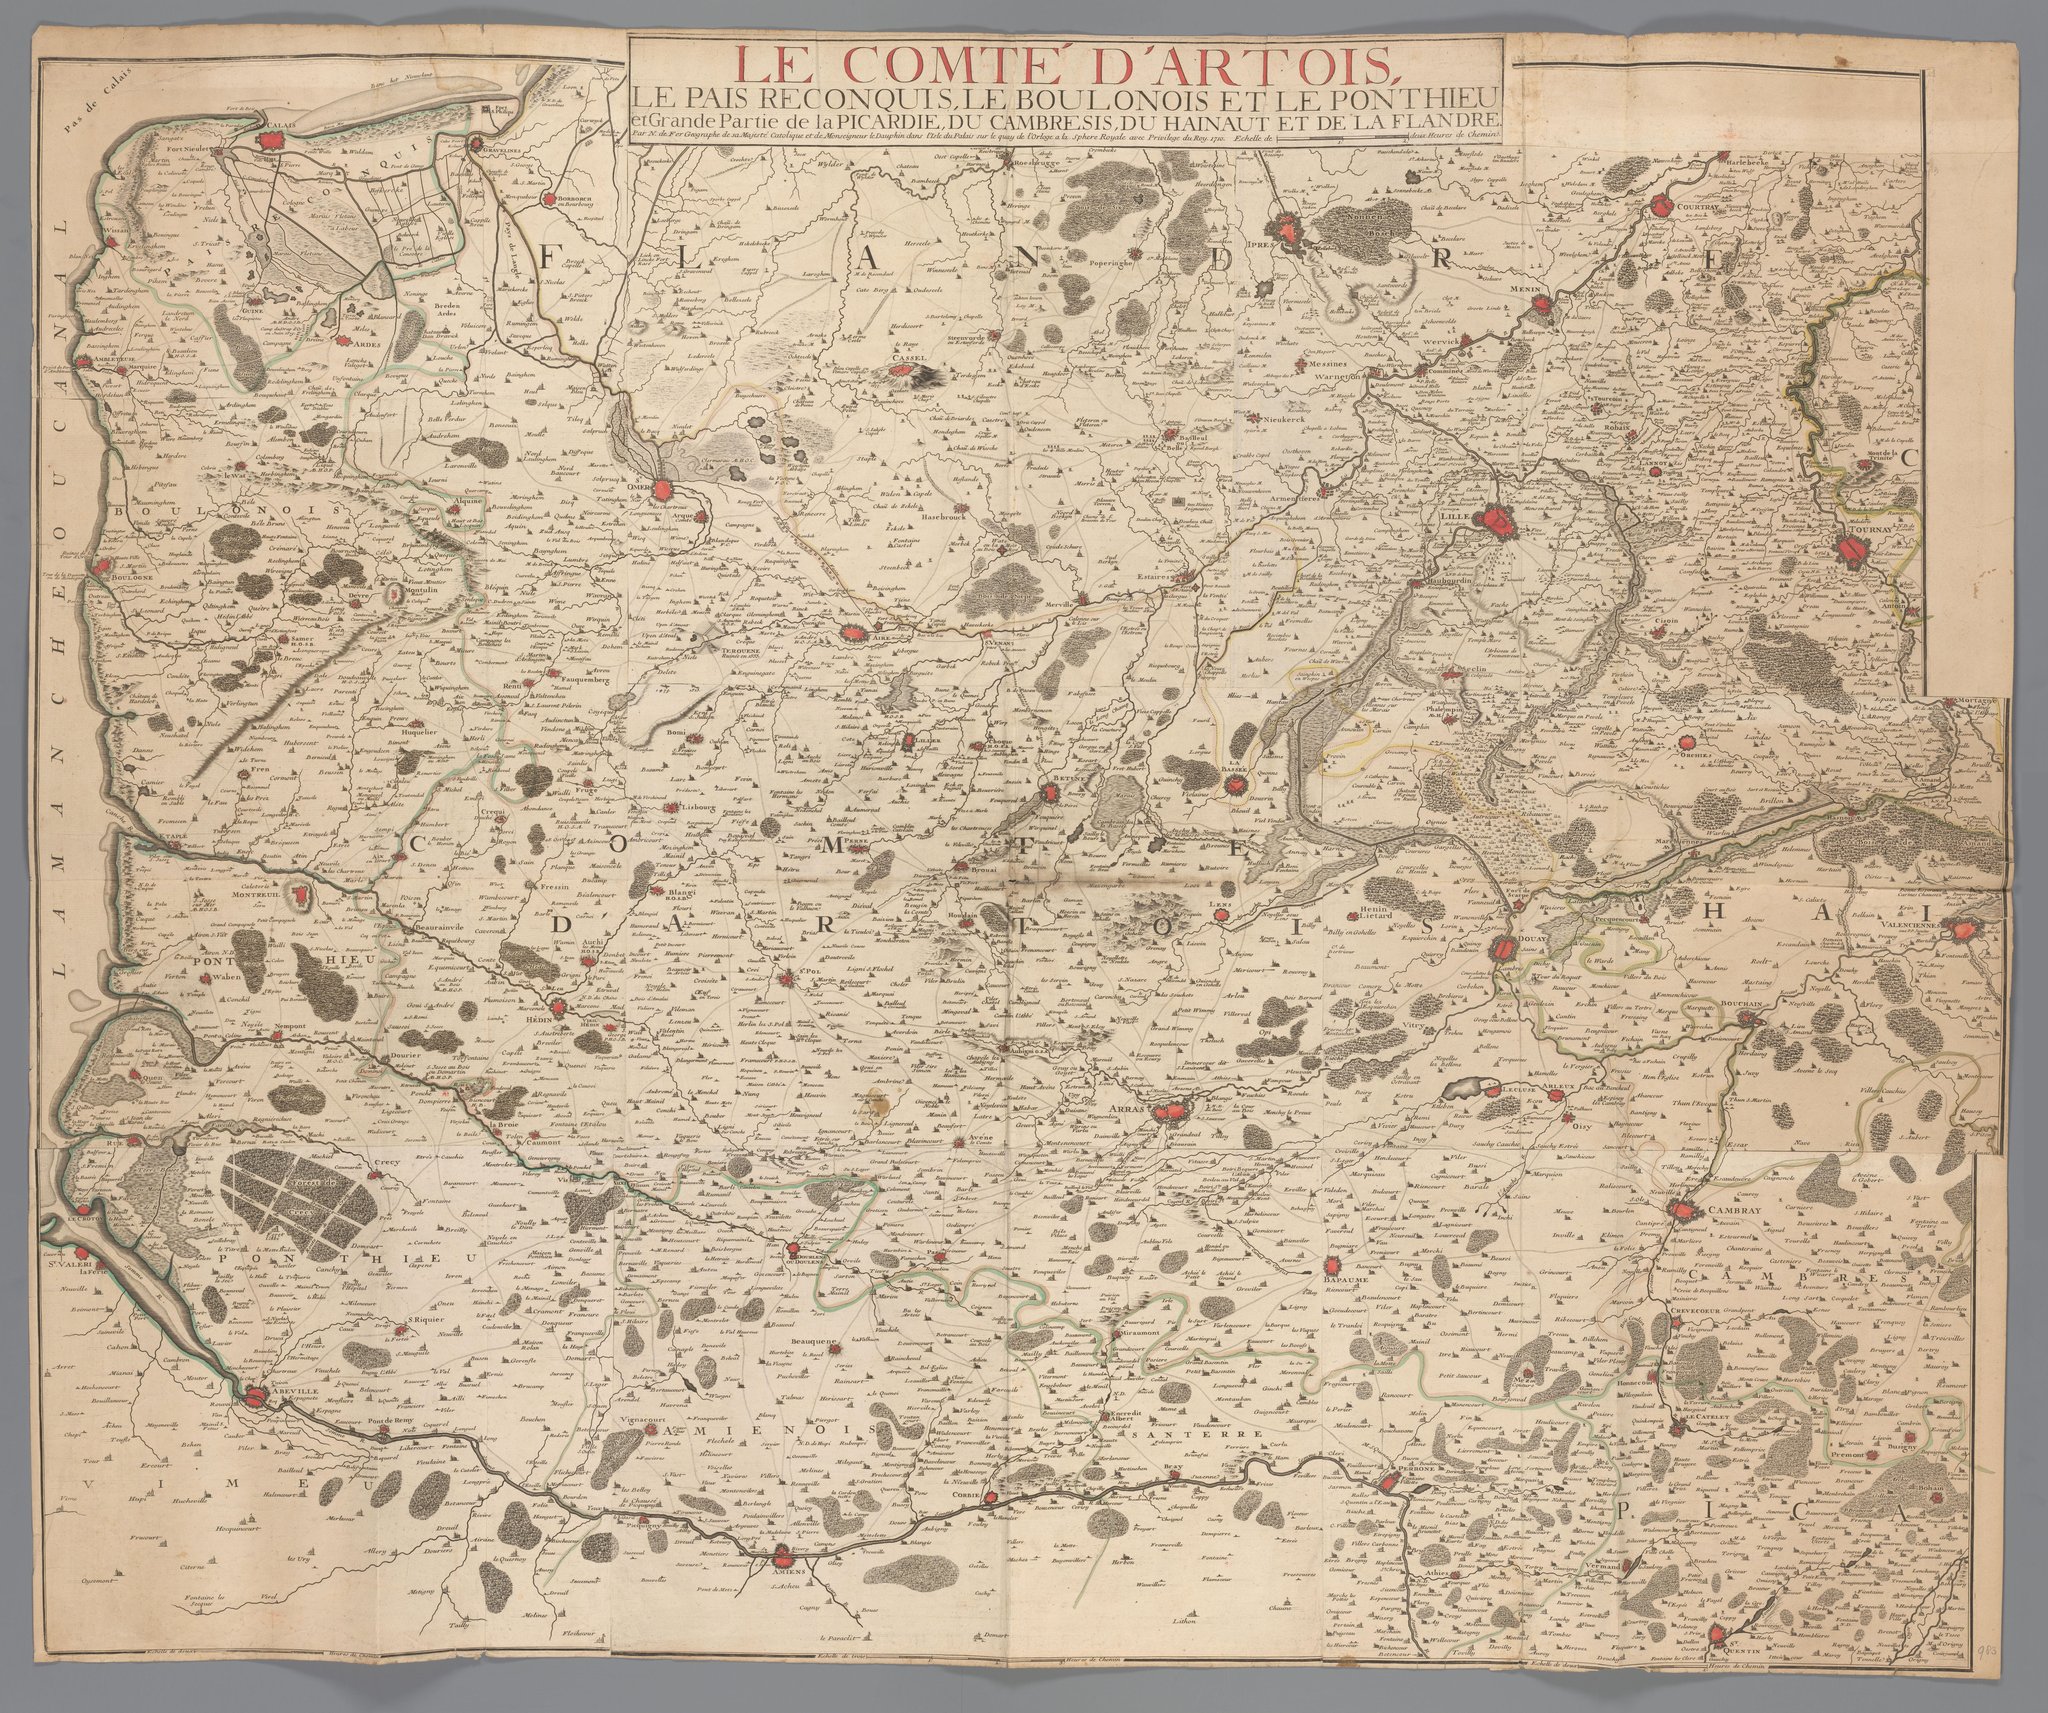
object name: print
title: Kaart van het graafschap Artesië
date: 1710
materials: paper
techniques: etching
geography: paris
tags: maps of separate countries or regions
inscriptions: date